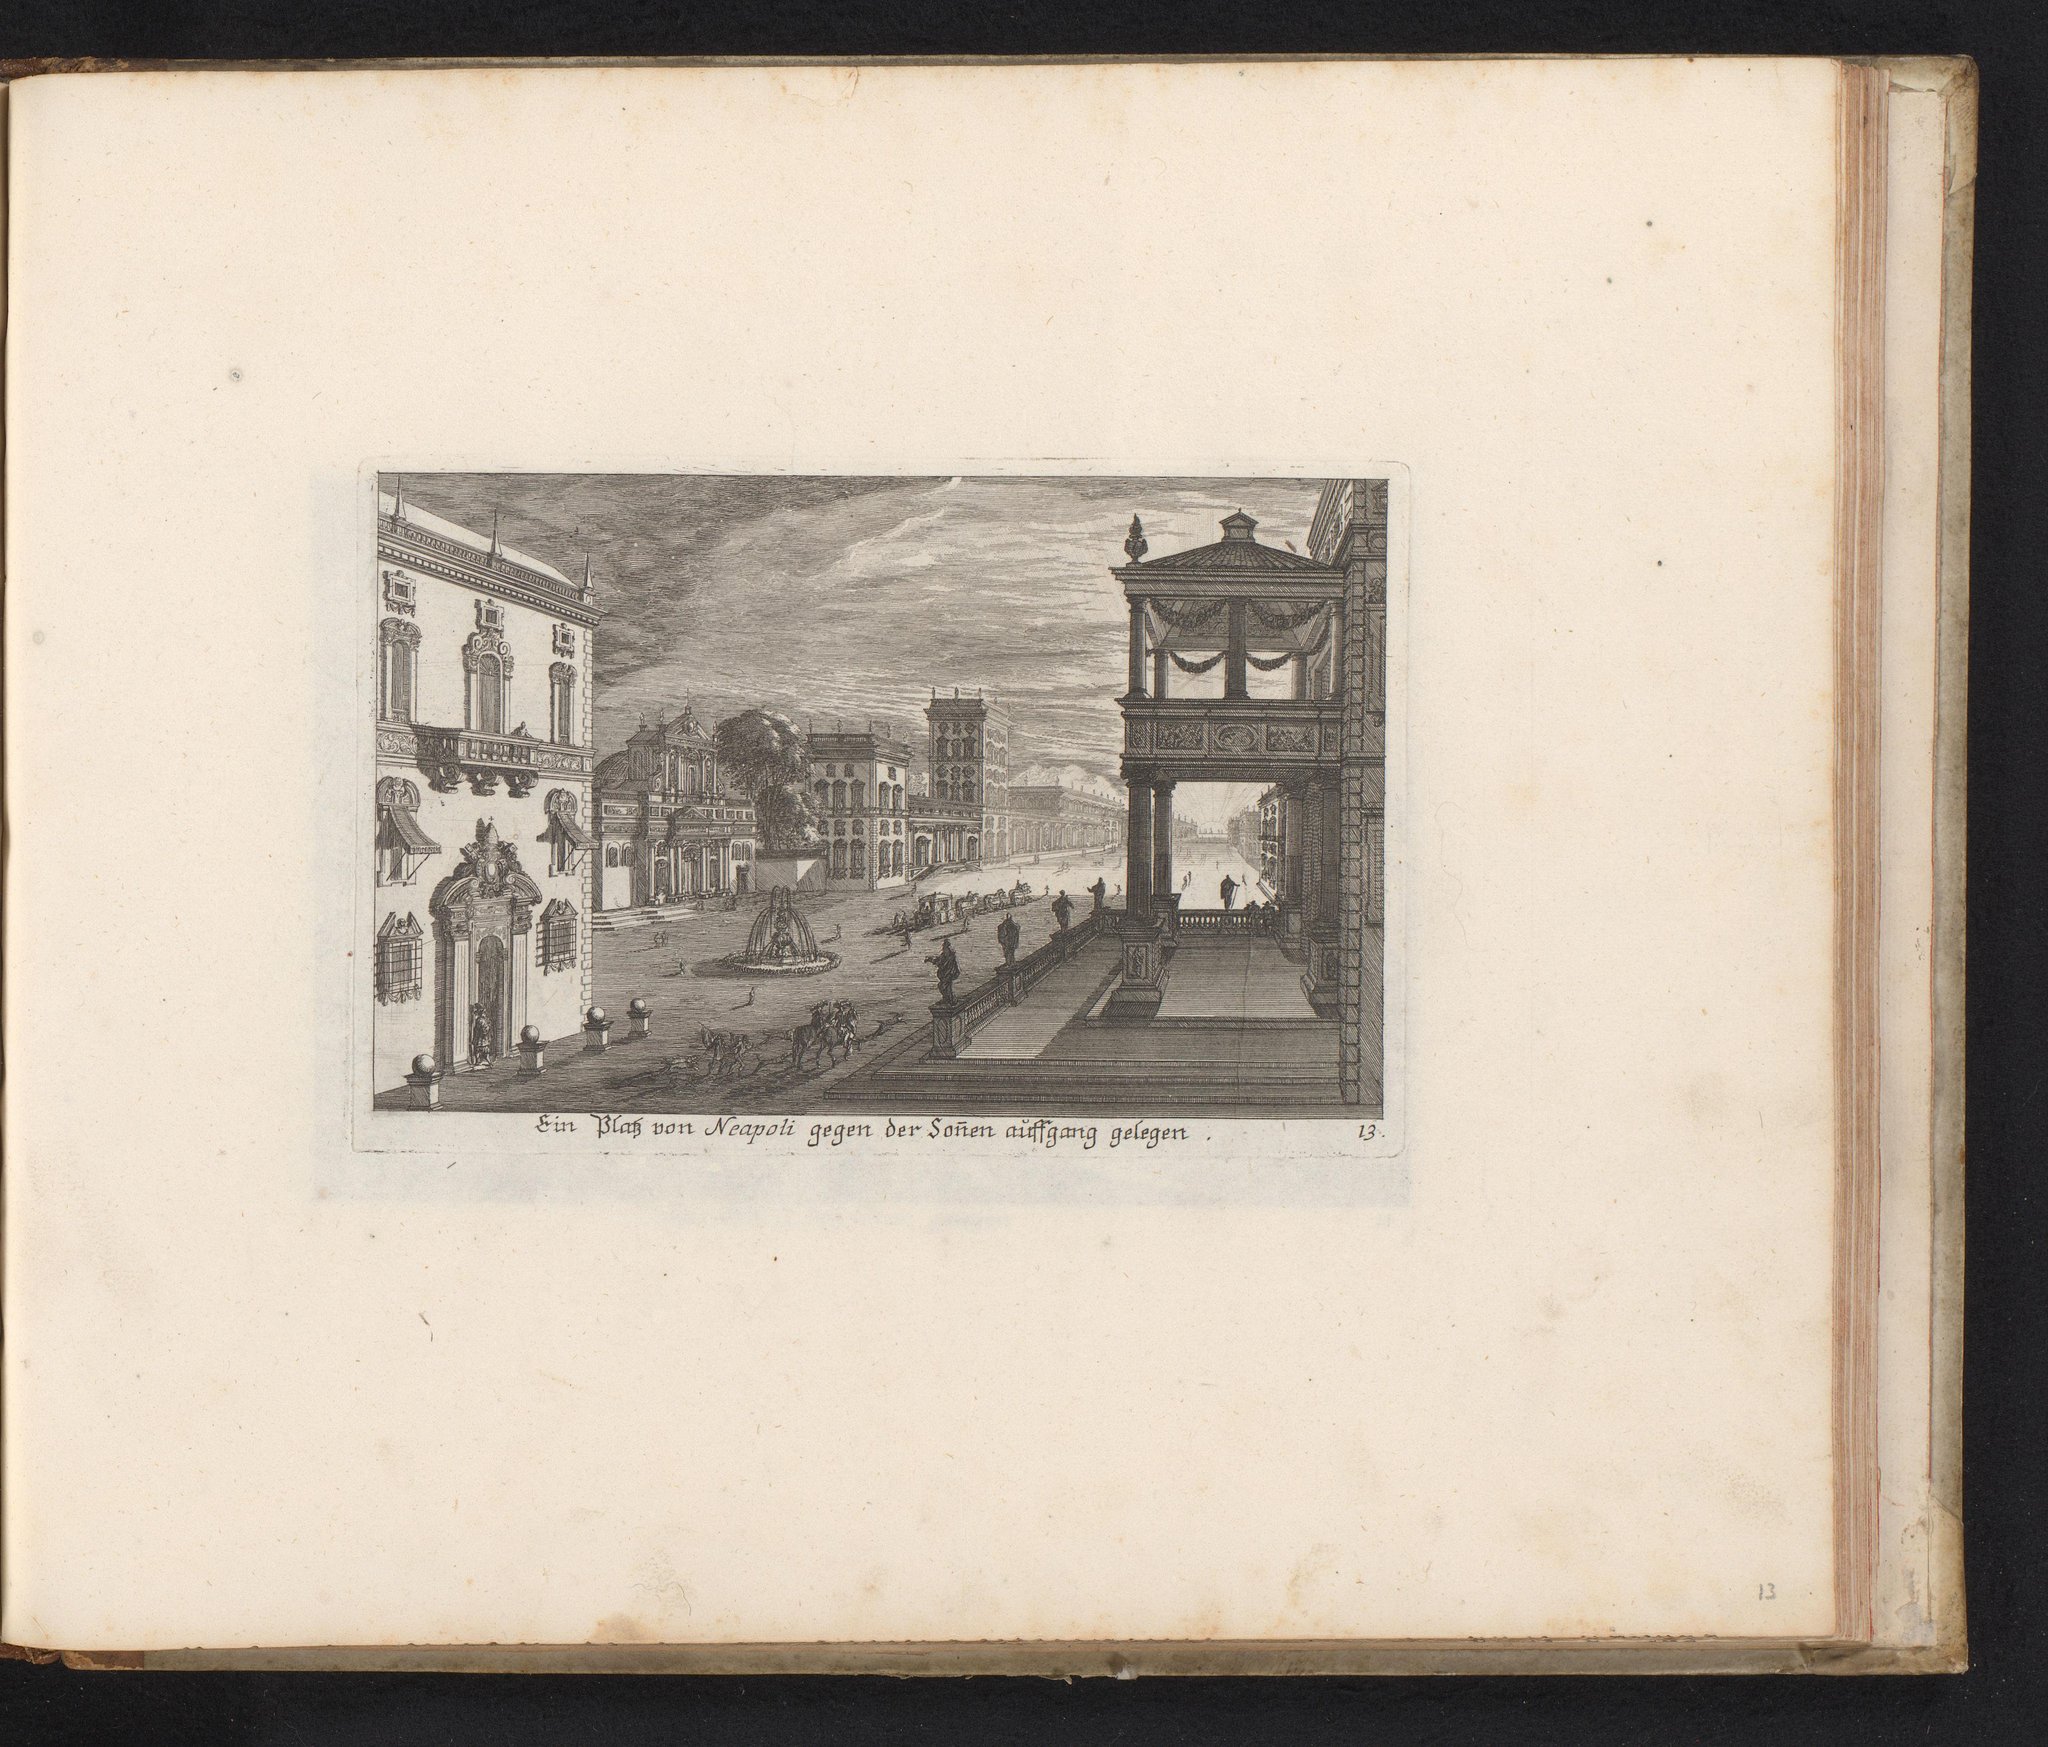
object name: album leaf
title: Gezicht op een plein in Napels bij zonsopkomst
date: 1670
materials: paper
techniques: etching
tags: square, place, circus, etc., sunrise, naples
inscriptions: collector's mark: Lugt 2228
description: Tekst in het Duits in de ondermarge. Rechtsonder genummerd: 13. Prent maakt deel uit van een album.